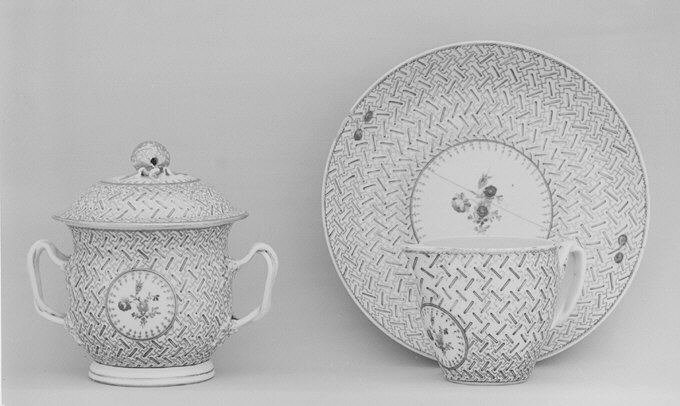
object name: sugar bowl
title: Sugar bowl (part of a service)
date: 1815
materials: hard paste porcelain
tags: flowers